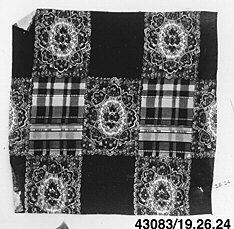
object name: sample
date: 1840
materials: cotton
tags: flowers